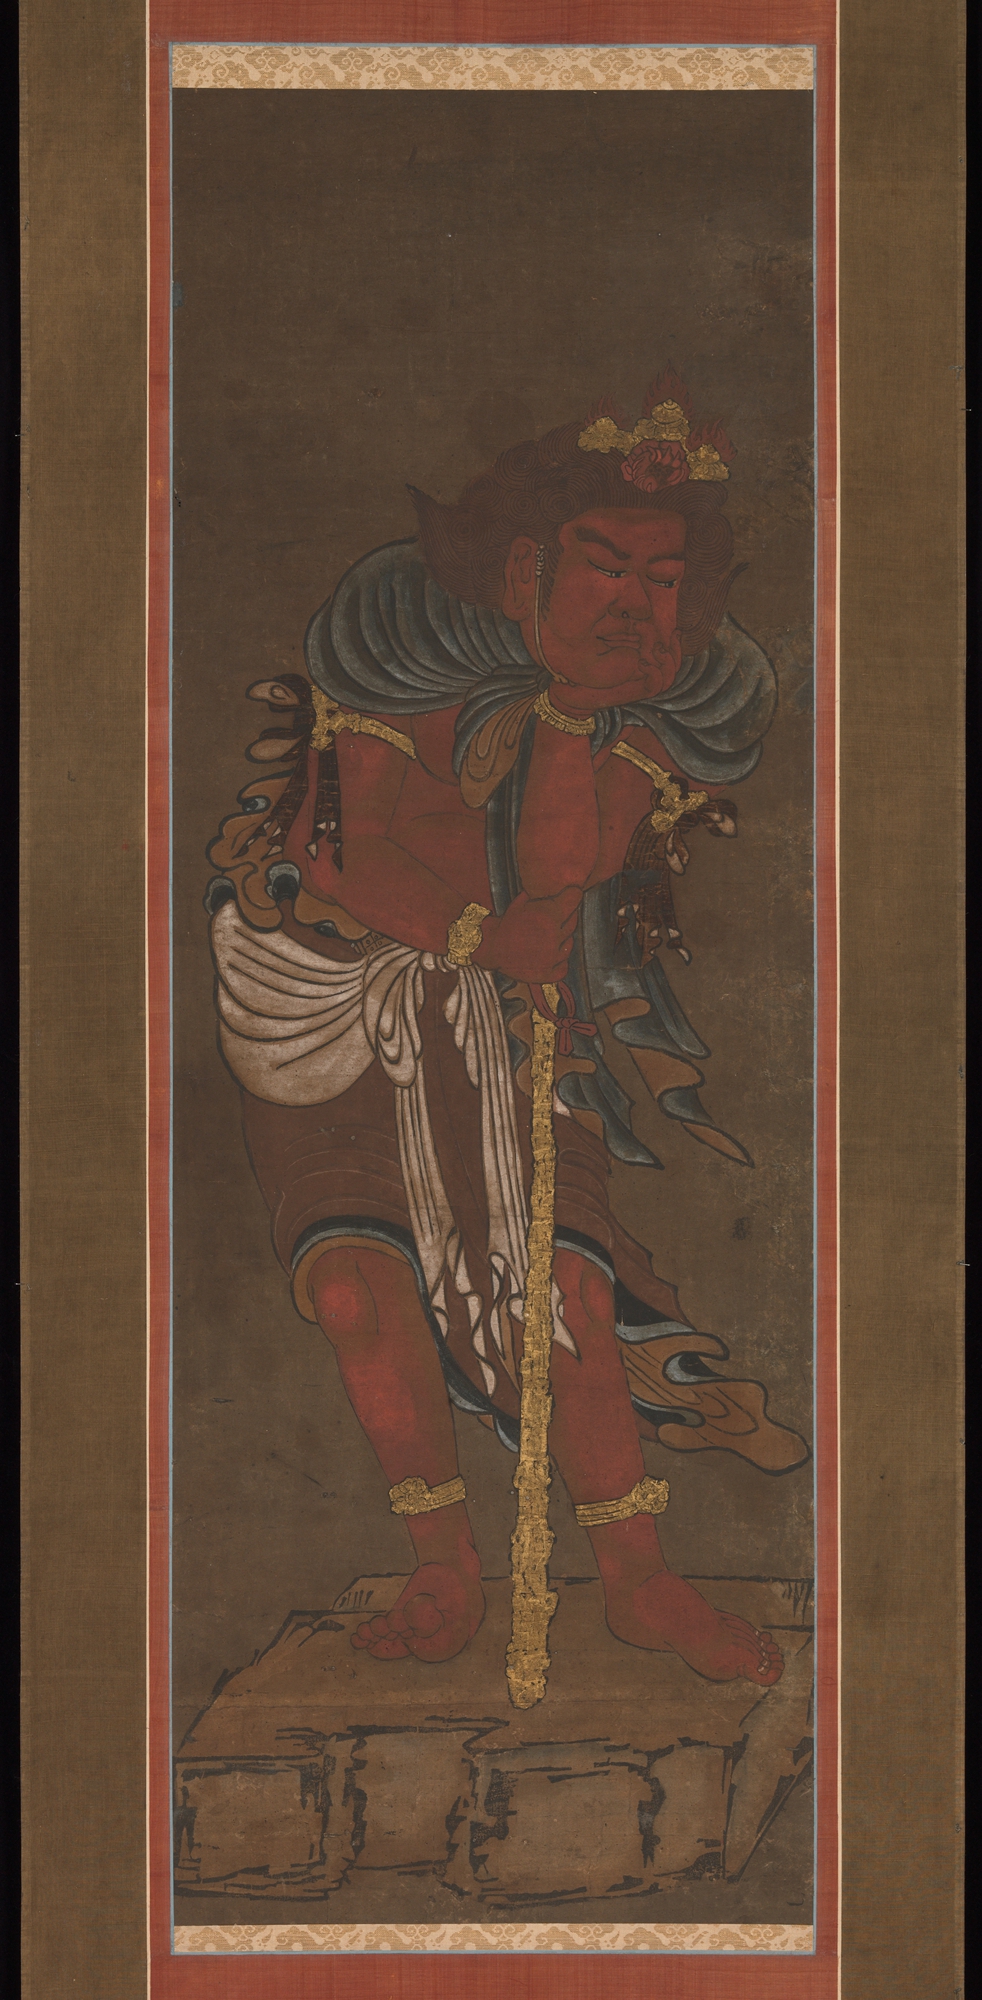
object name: hanging scroll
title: Fudō Myōō and Two Attendants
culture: japanese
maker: ryūshū shūtaku (myōtaku)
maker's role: artist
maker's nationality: japanese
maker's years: 1307-1388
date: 1301-1400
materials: paper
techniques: hand coloring, woodblock print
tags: men,buddhism